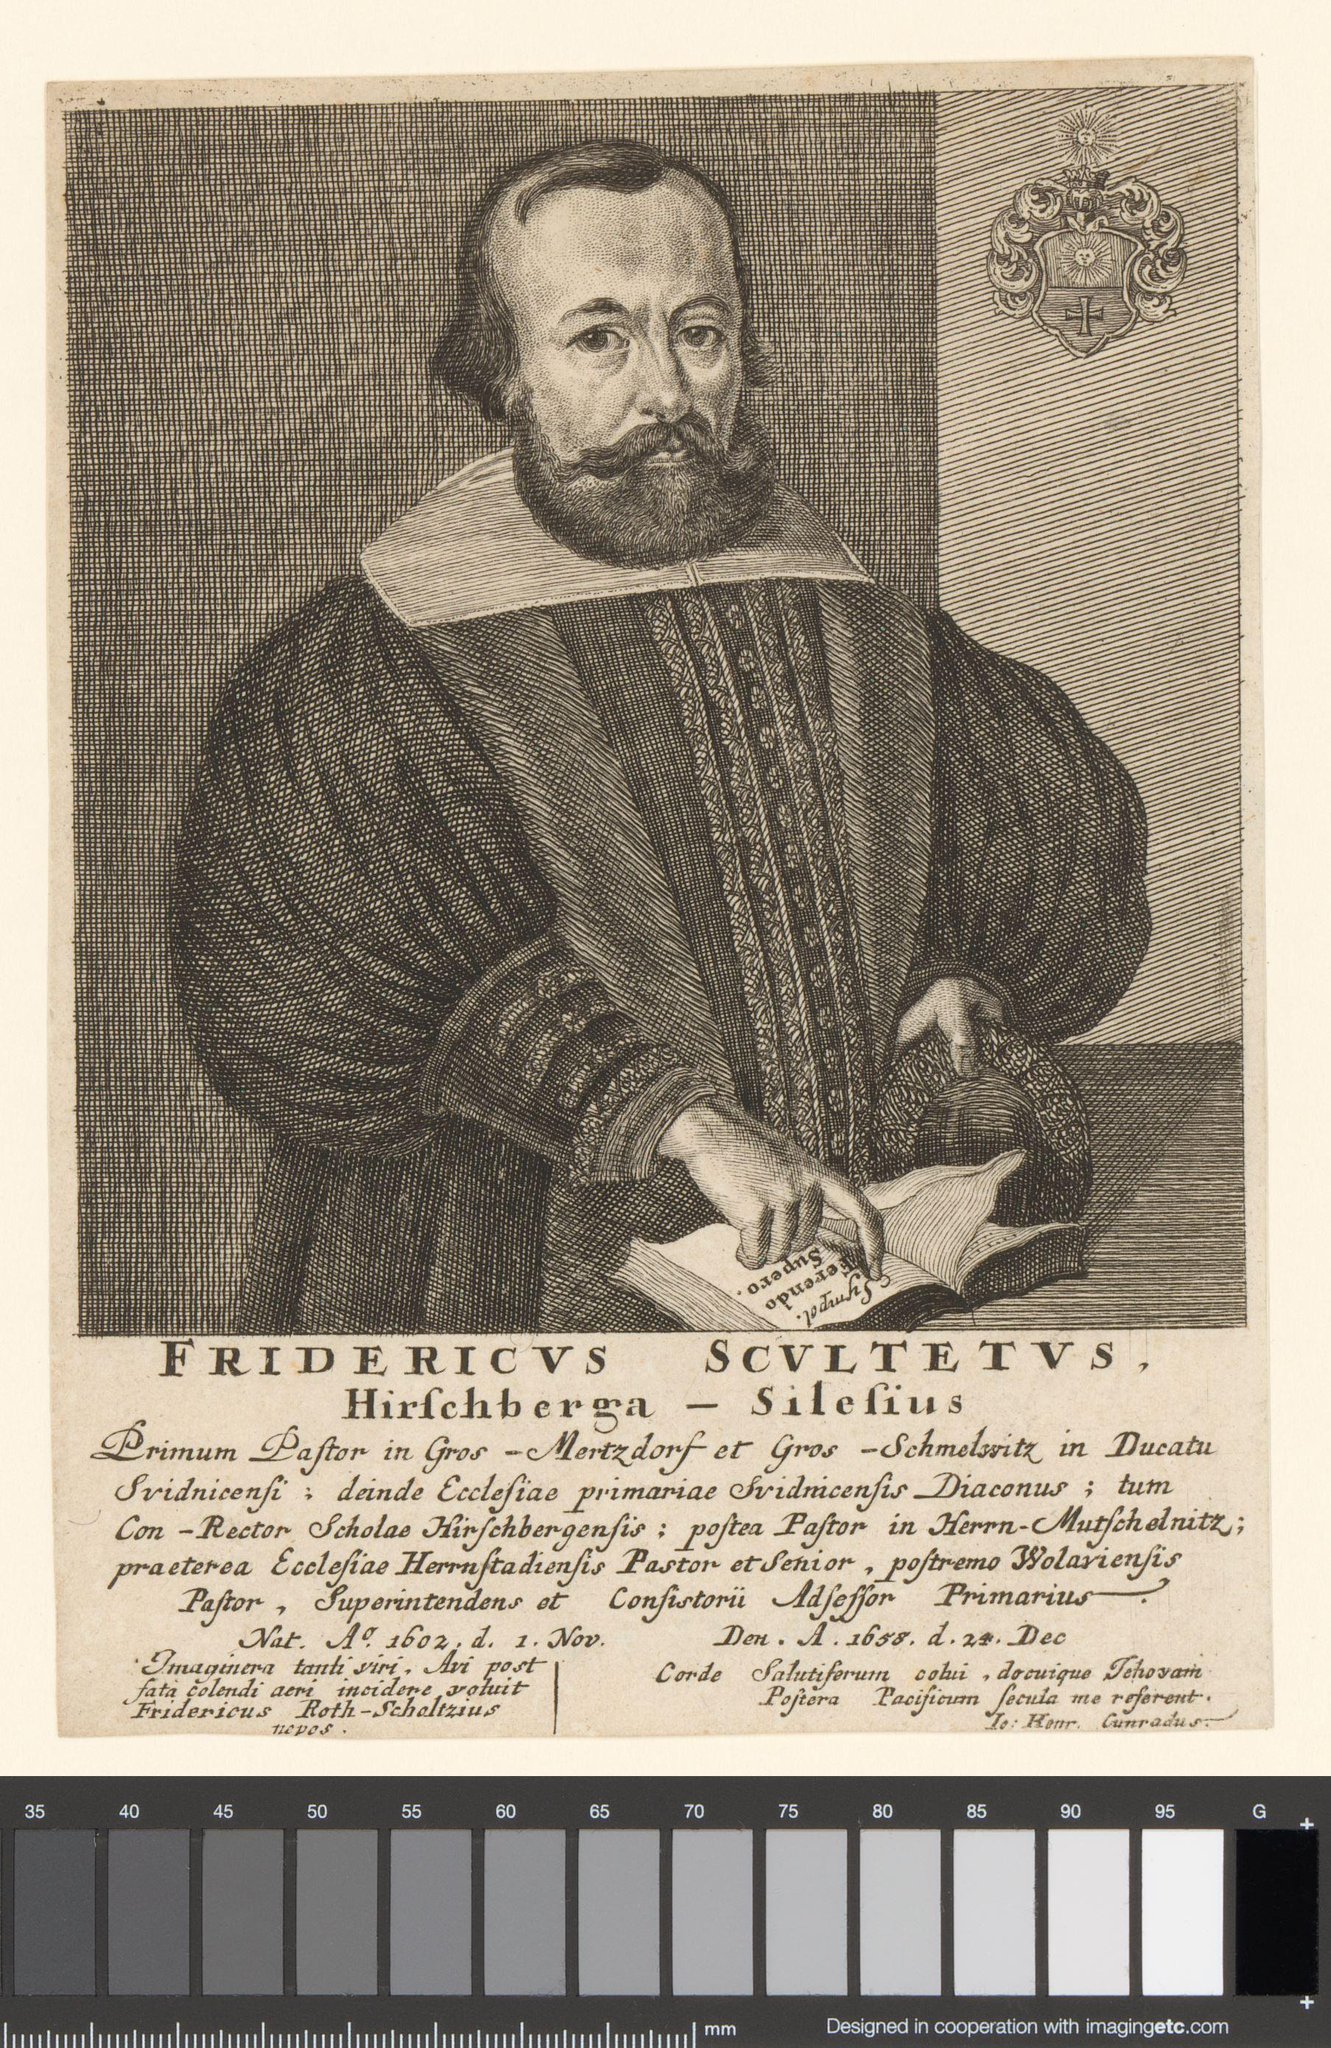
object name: print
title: Portret van Friedrich Scultetus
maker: fridericus roth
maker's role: print maker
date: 1658-1699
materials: paper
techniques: engraving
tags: historical persons, book, armorial bearing, heraldry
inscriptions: collector's mark: Lugt 2228